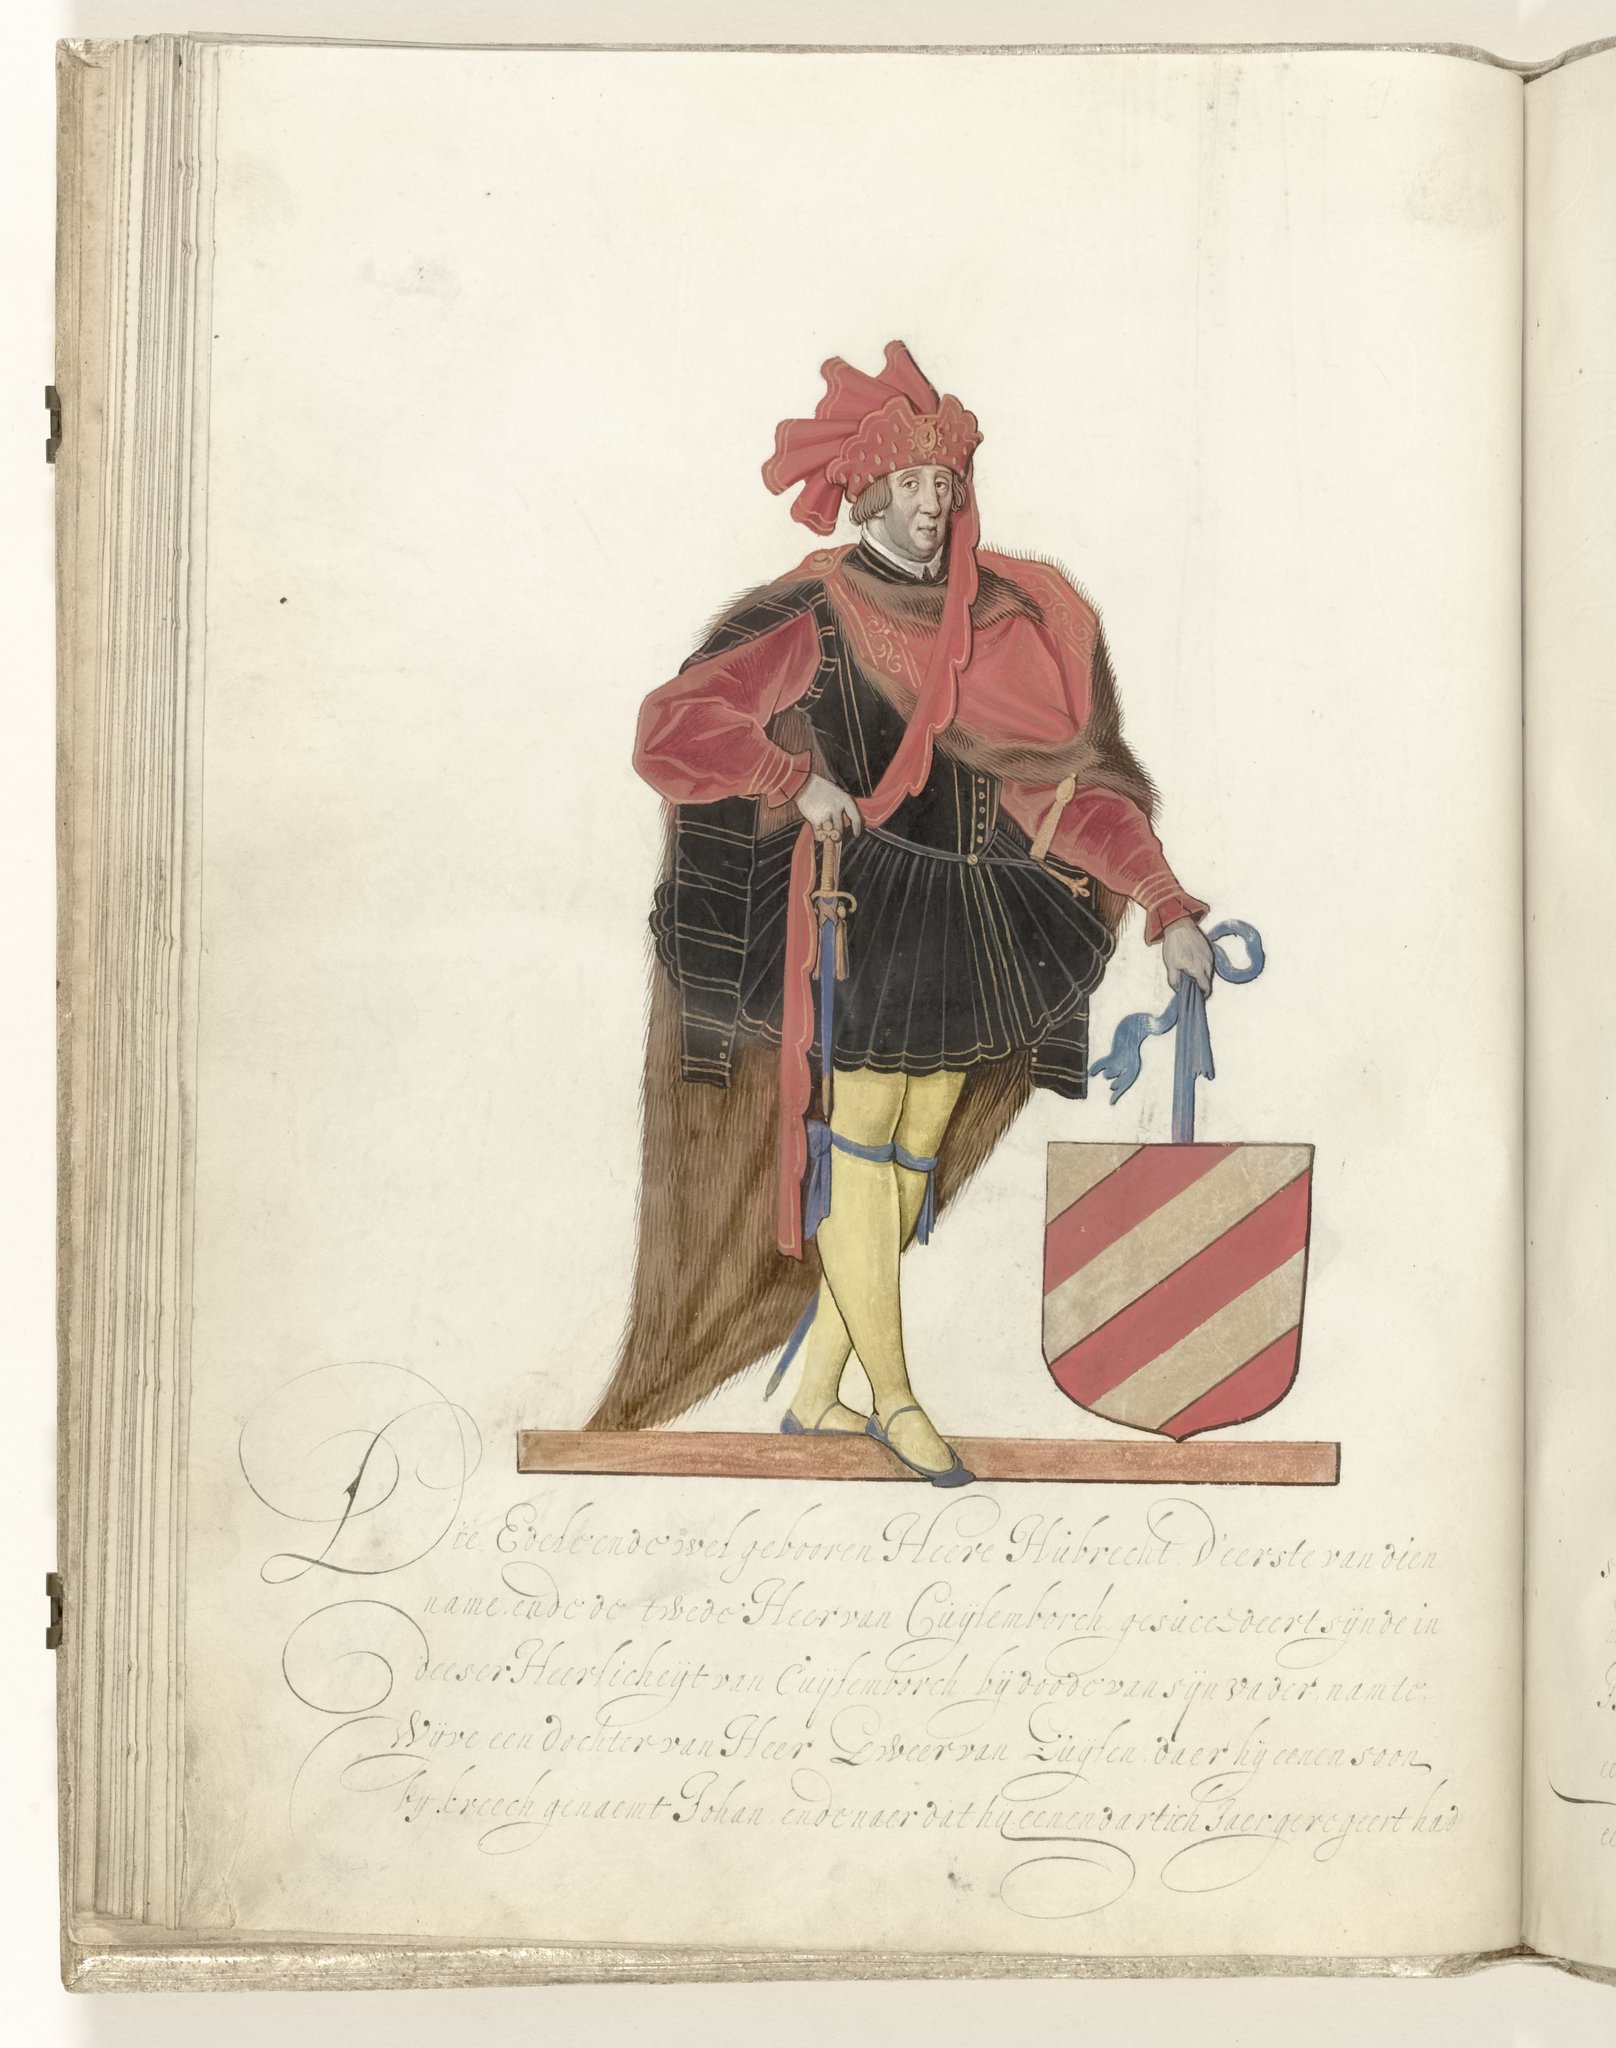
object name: drawing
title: Hubrecht, heer van Culemborg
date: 1590-1593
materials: paint, gouache, ink, parchment, watercolor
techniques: writing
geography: northern netherlands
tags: culemborg, heren en graven van, heren van beusichem, hubrecht heer van culemborg, culemborg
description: Hubrecht van Beusechim, (tweede) heer van Culemborg. Staande ten voeten uit met het wapen van Beusichem. Onderdeel van een geïllustreerd handschrift met de genealogie van de heren en graven van Culemborg.